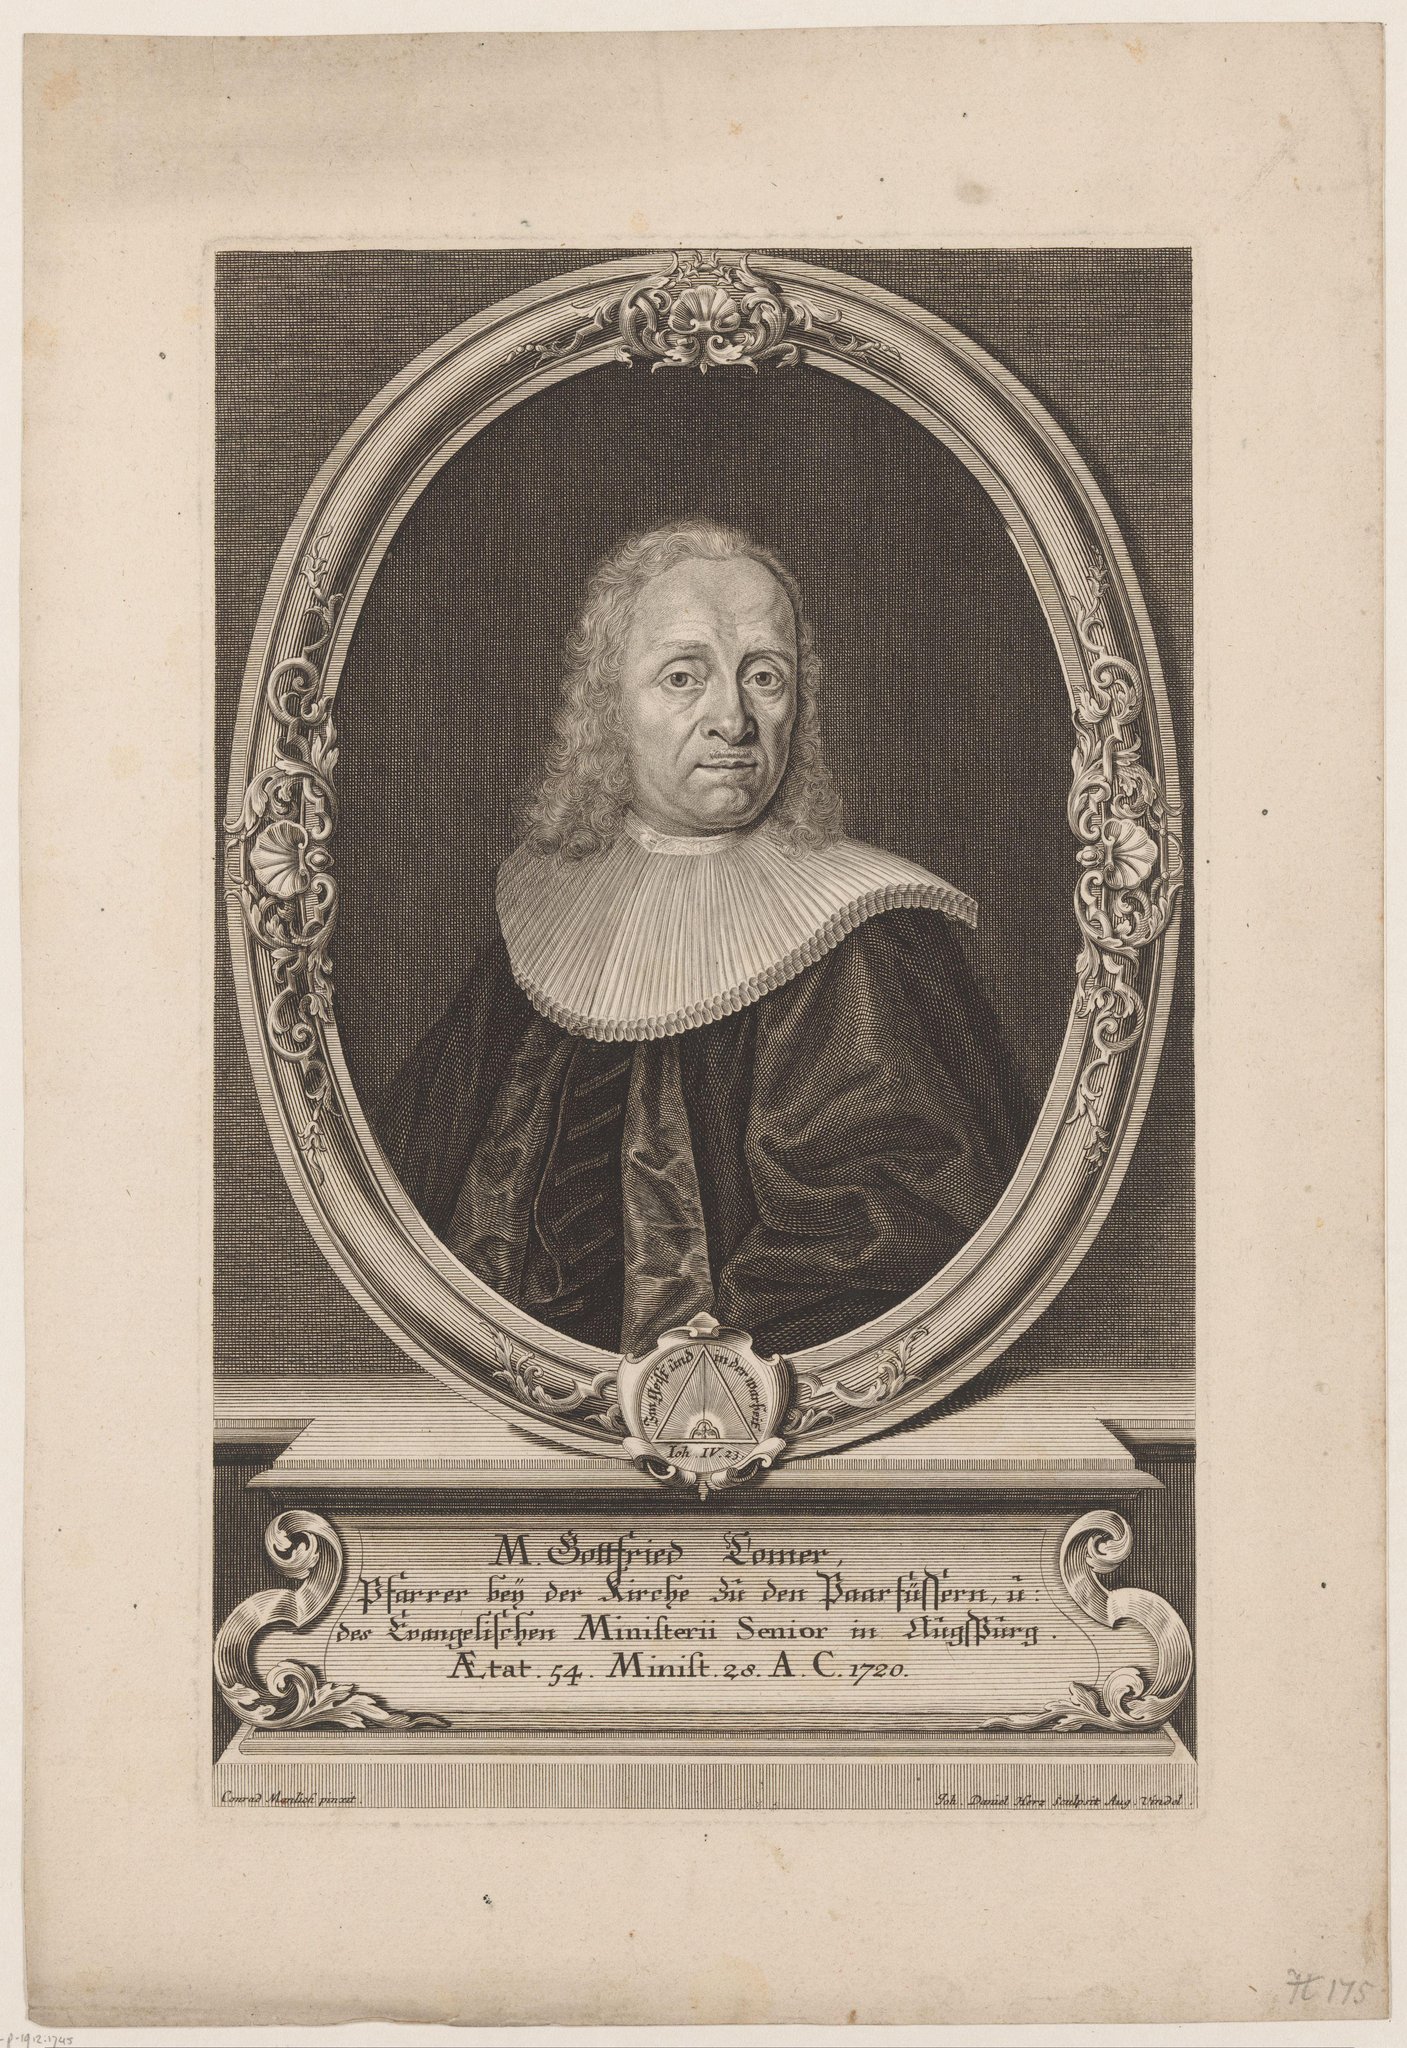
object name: print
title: Portret van Gottfried Lomer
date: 1720-1754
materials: paper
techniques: engraving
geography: augsburg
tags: augsburg, historical persons, abstract ideas and concepts (+ emblematical representation of concept)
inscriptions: collector's mark: Lugt 2228